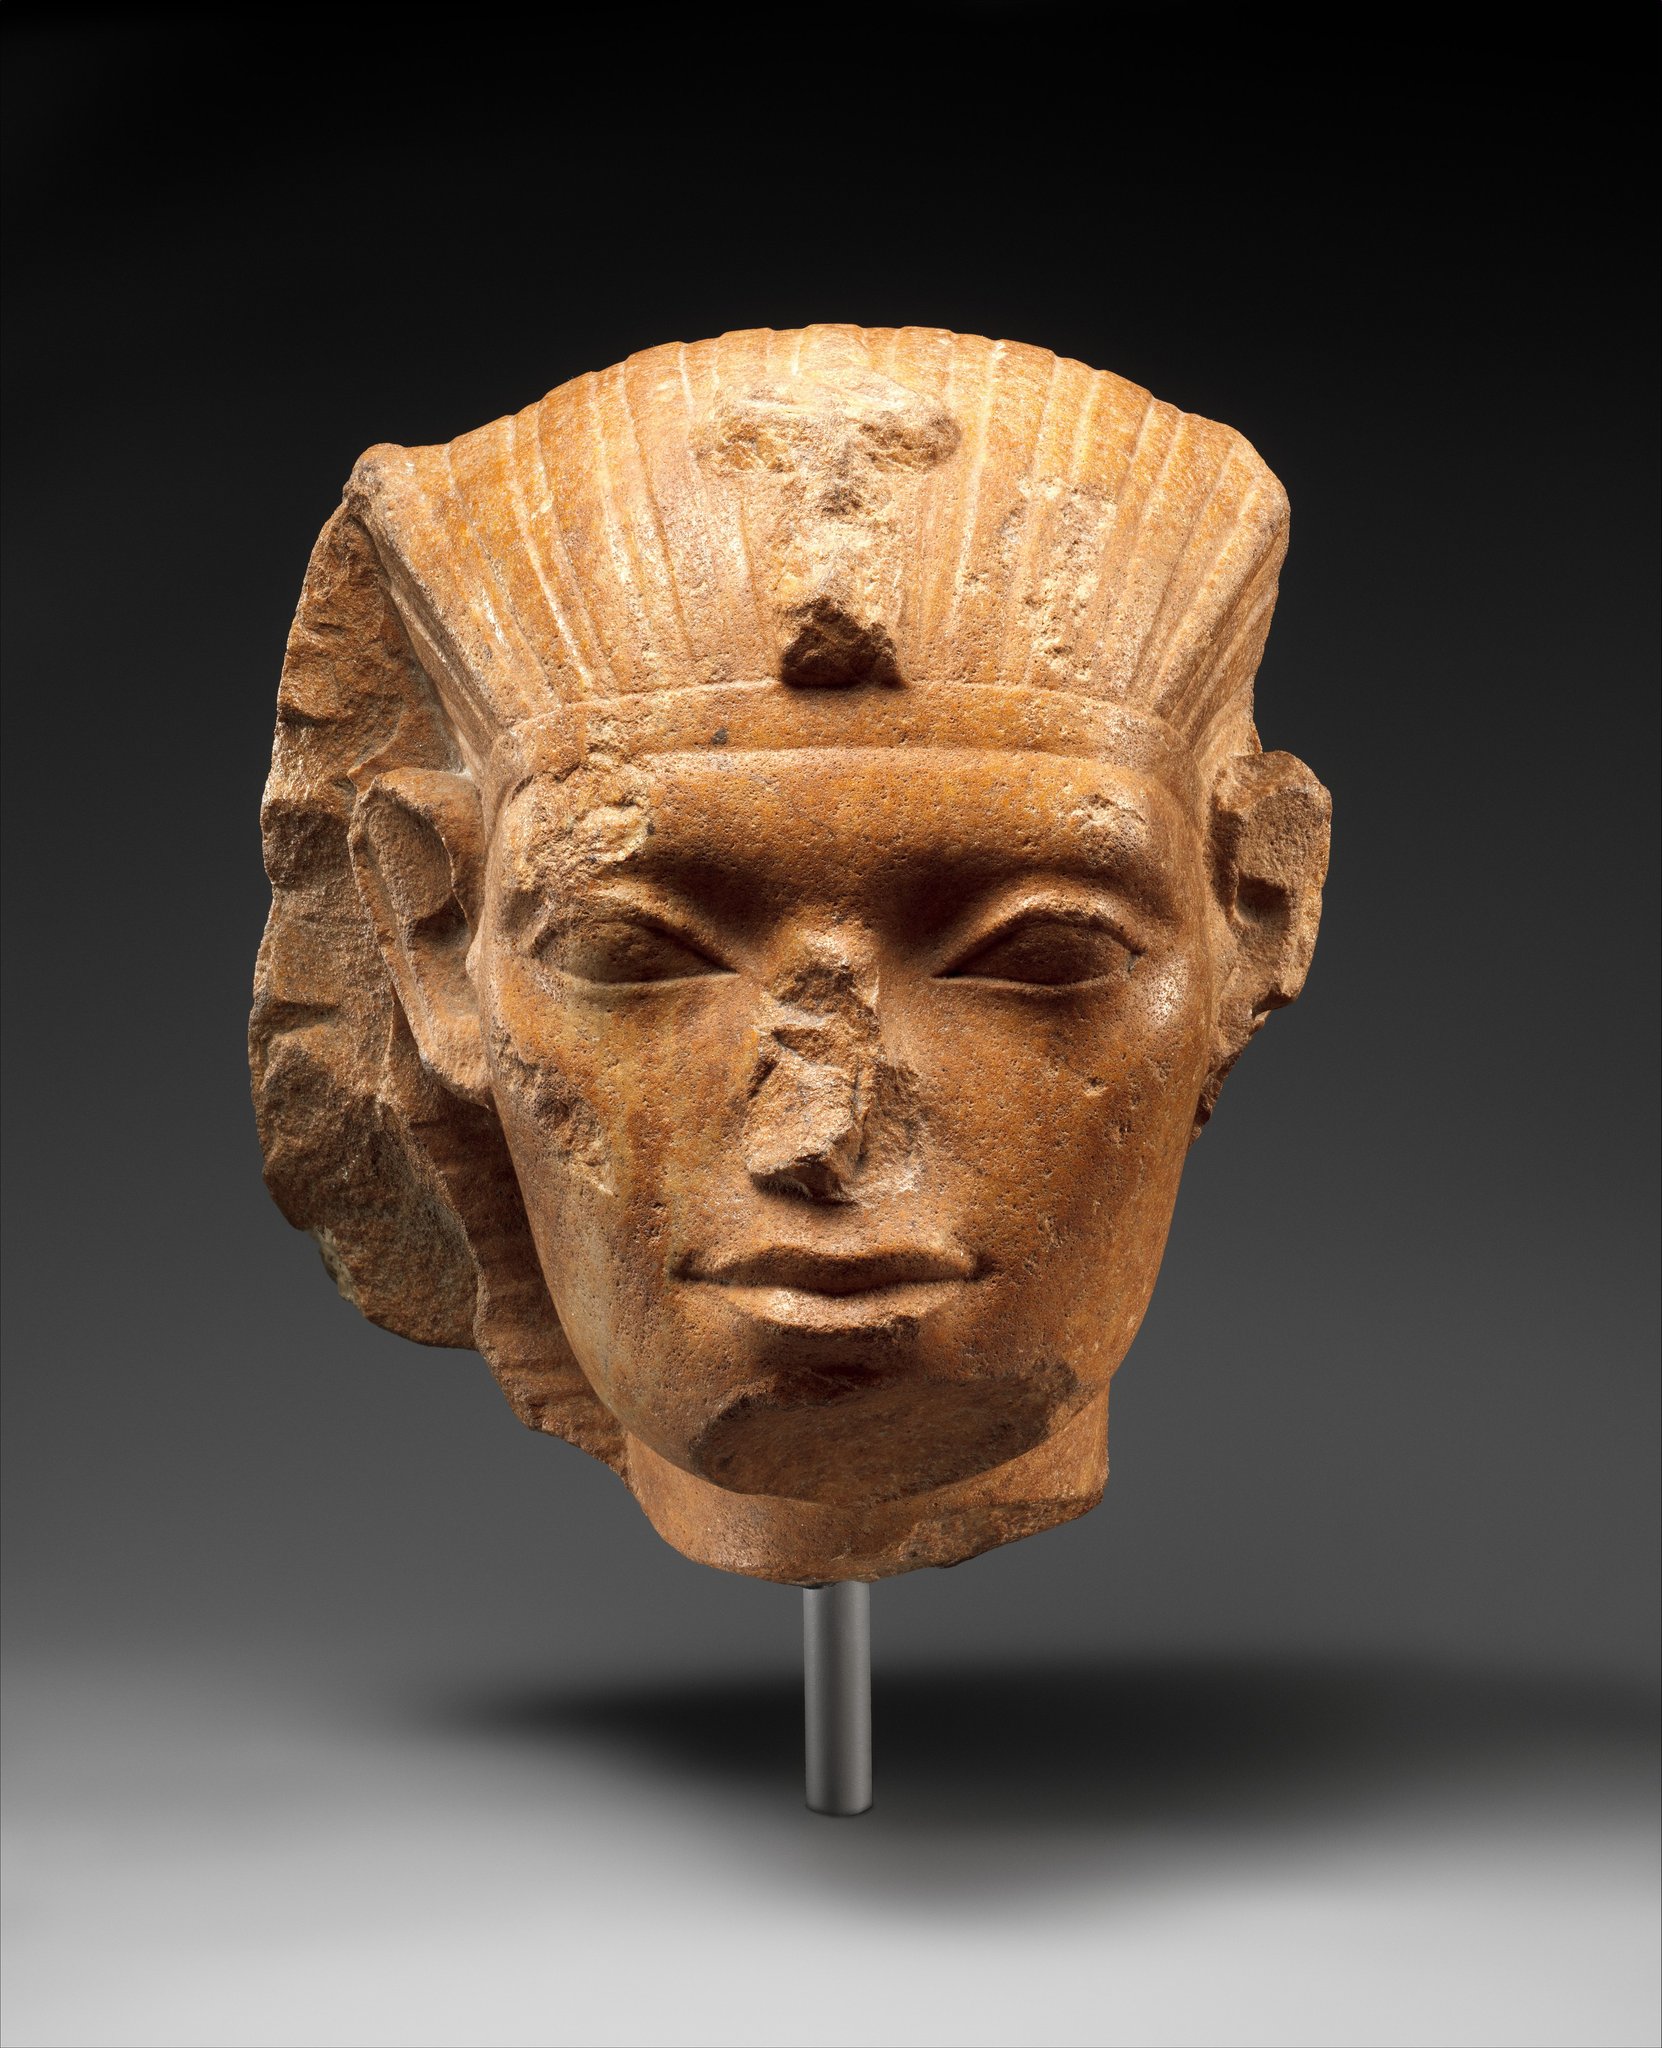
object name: head, king, nemes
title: Head of a King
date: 1802-1749 BCE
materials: quartzite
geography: egypt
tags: kings,heads,mk-kings